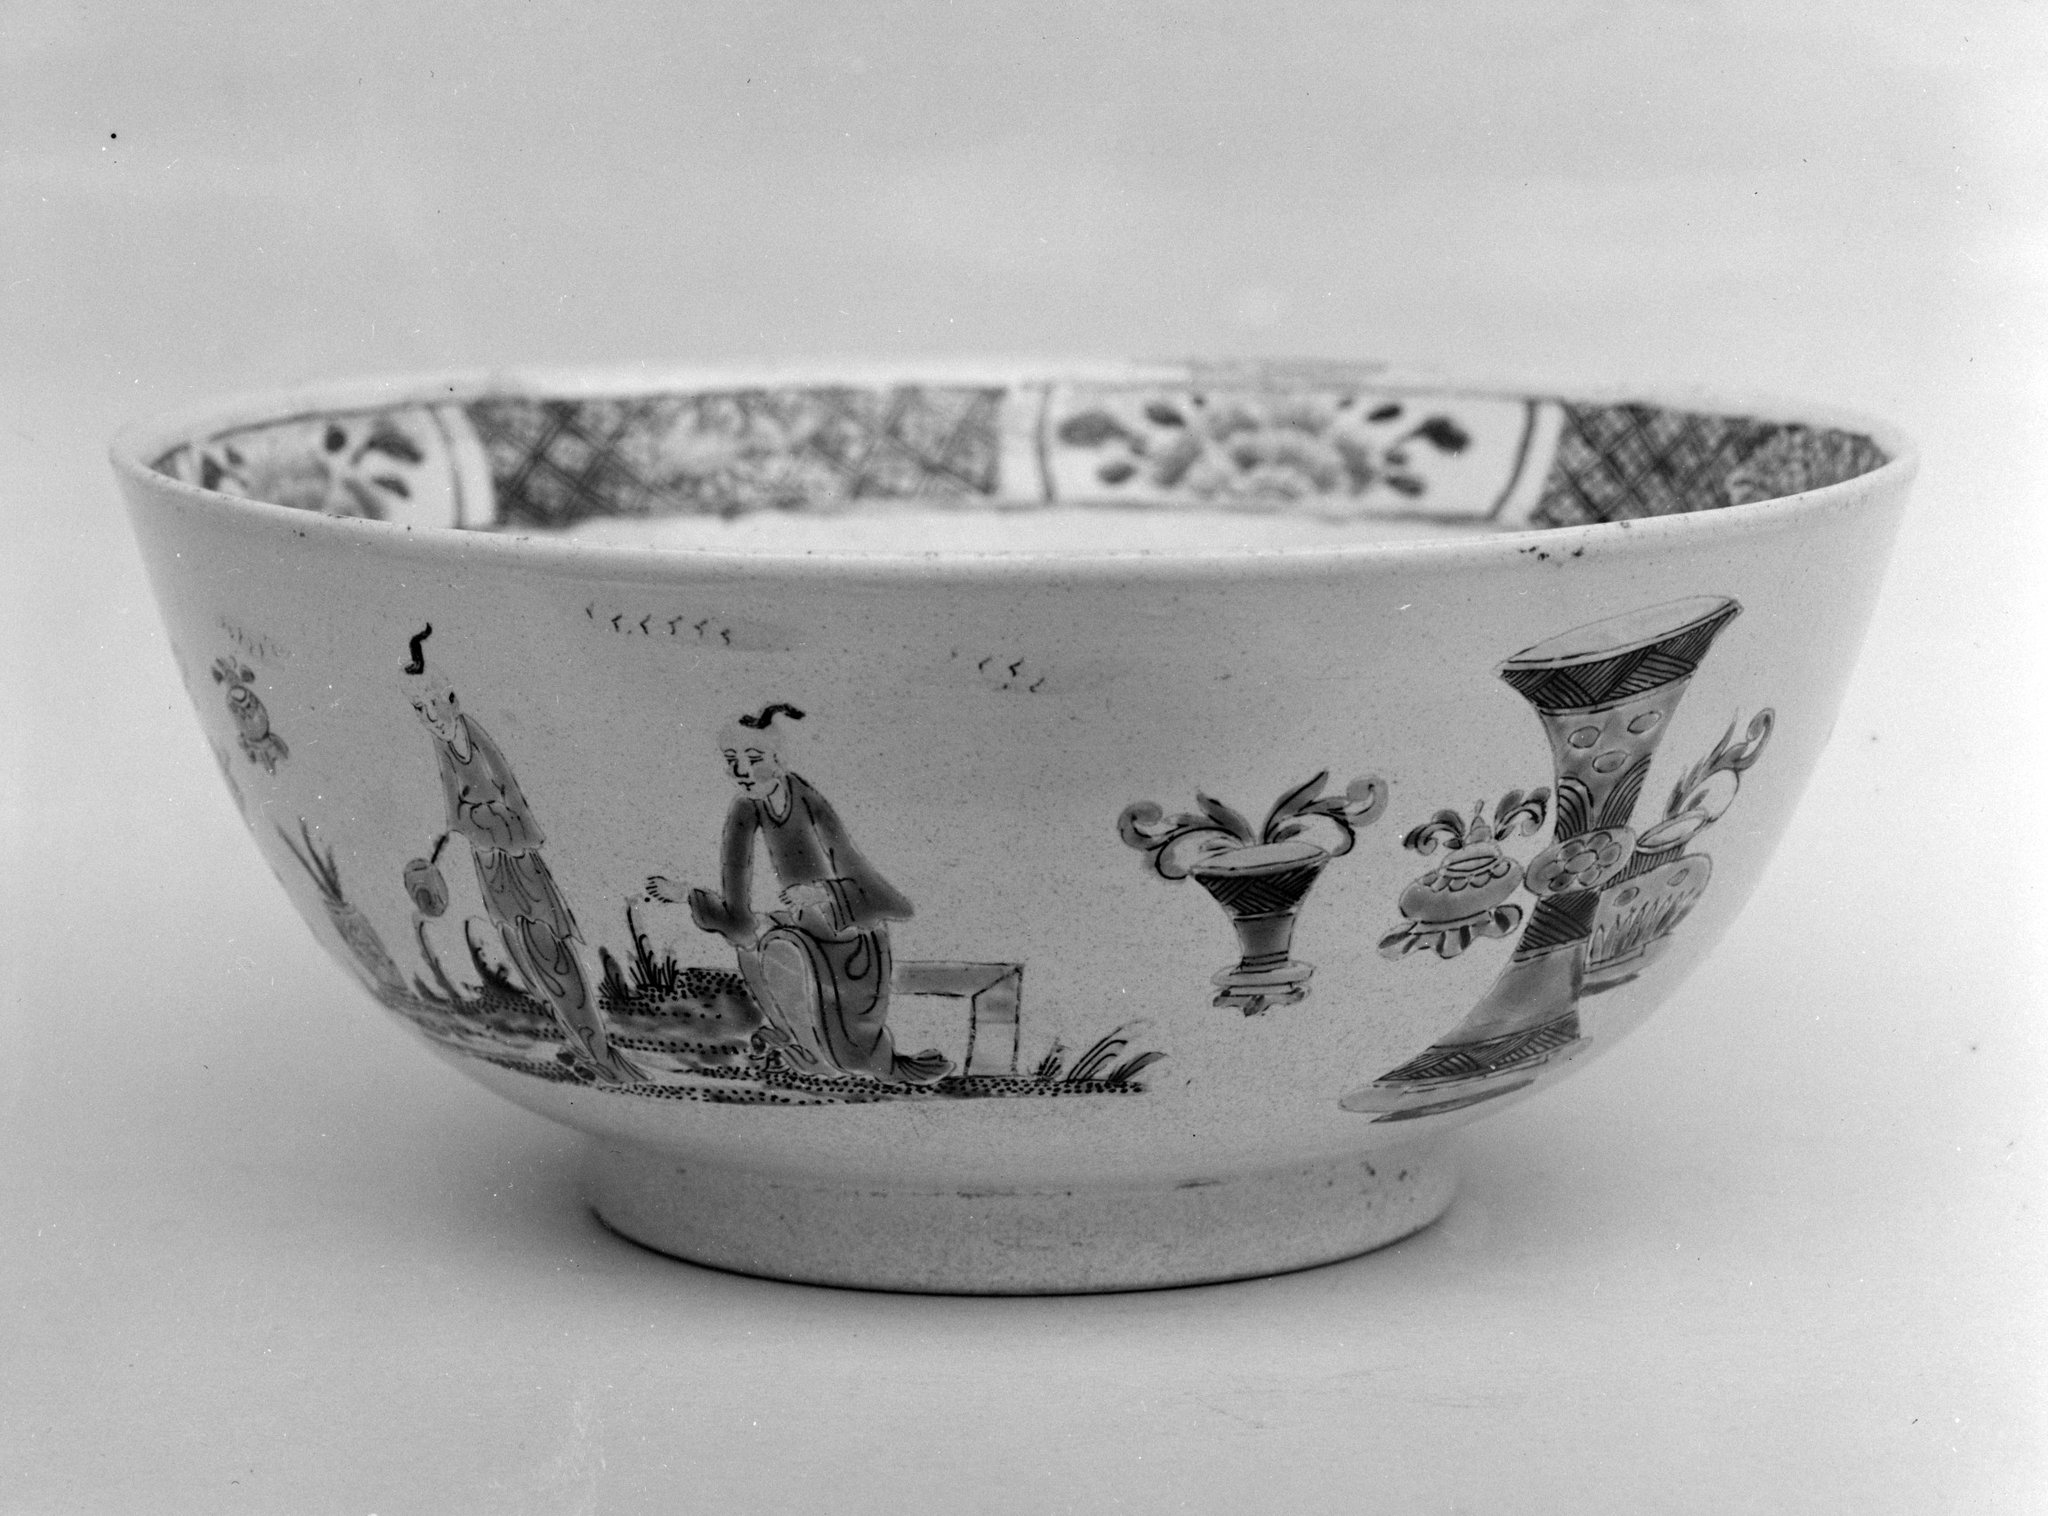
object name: bowl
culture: british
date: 1750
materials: stoneware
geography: england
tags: men